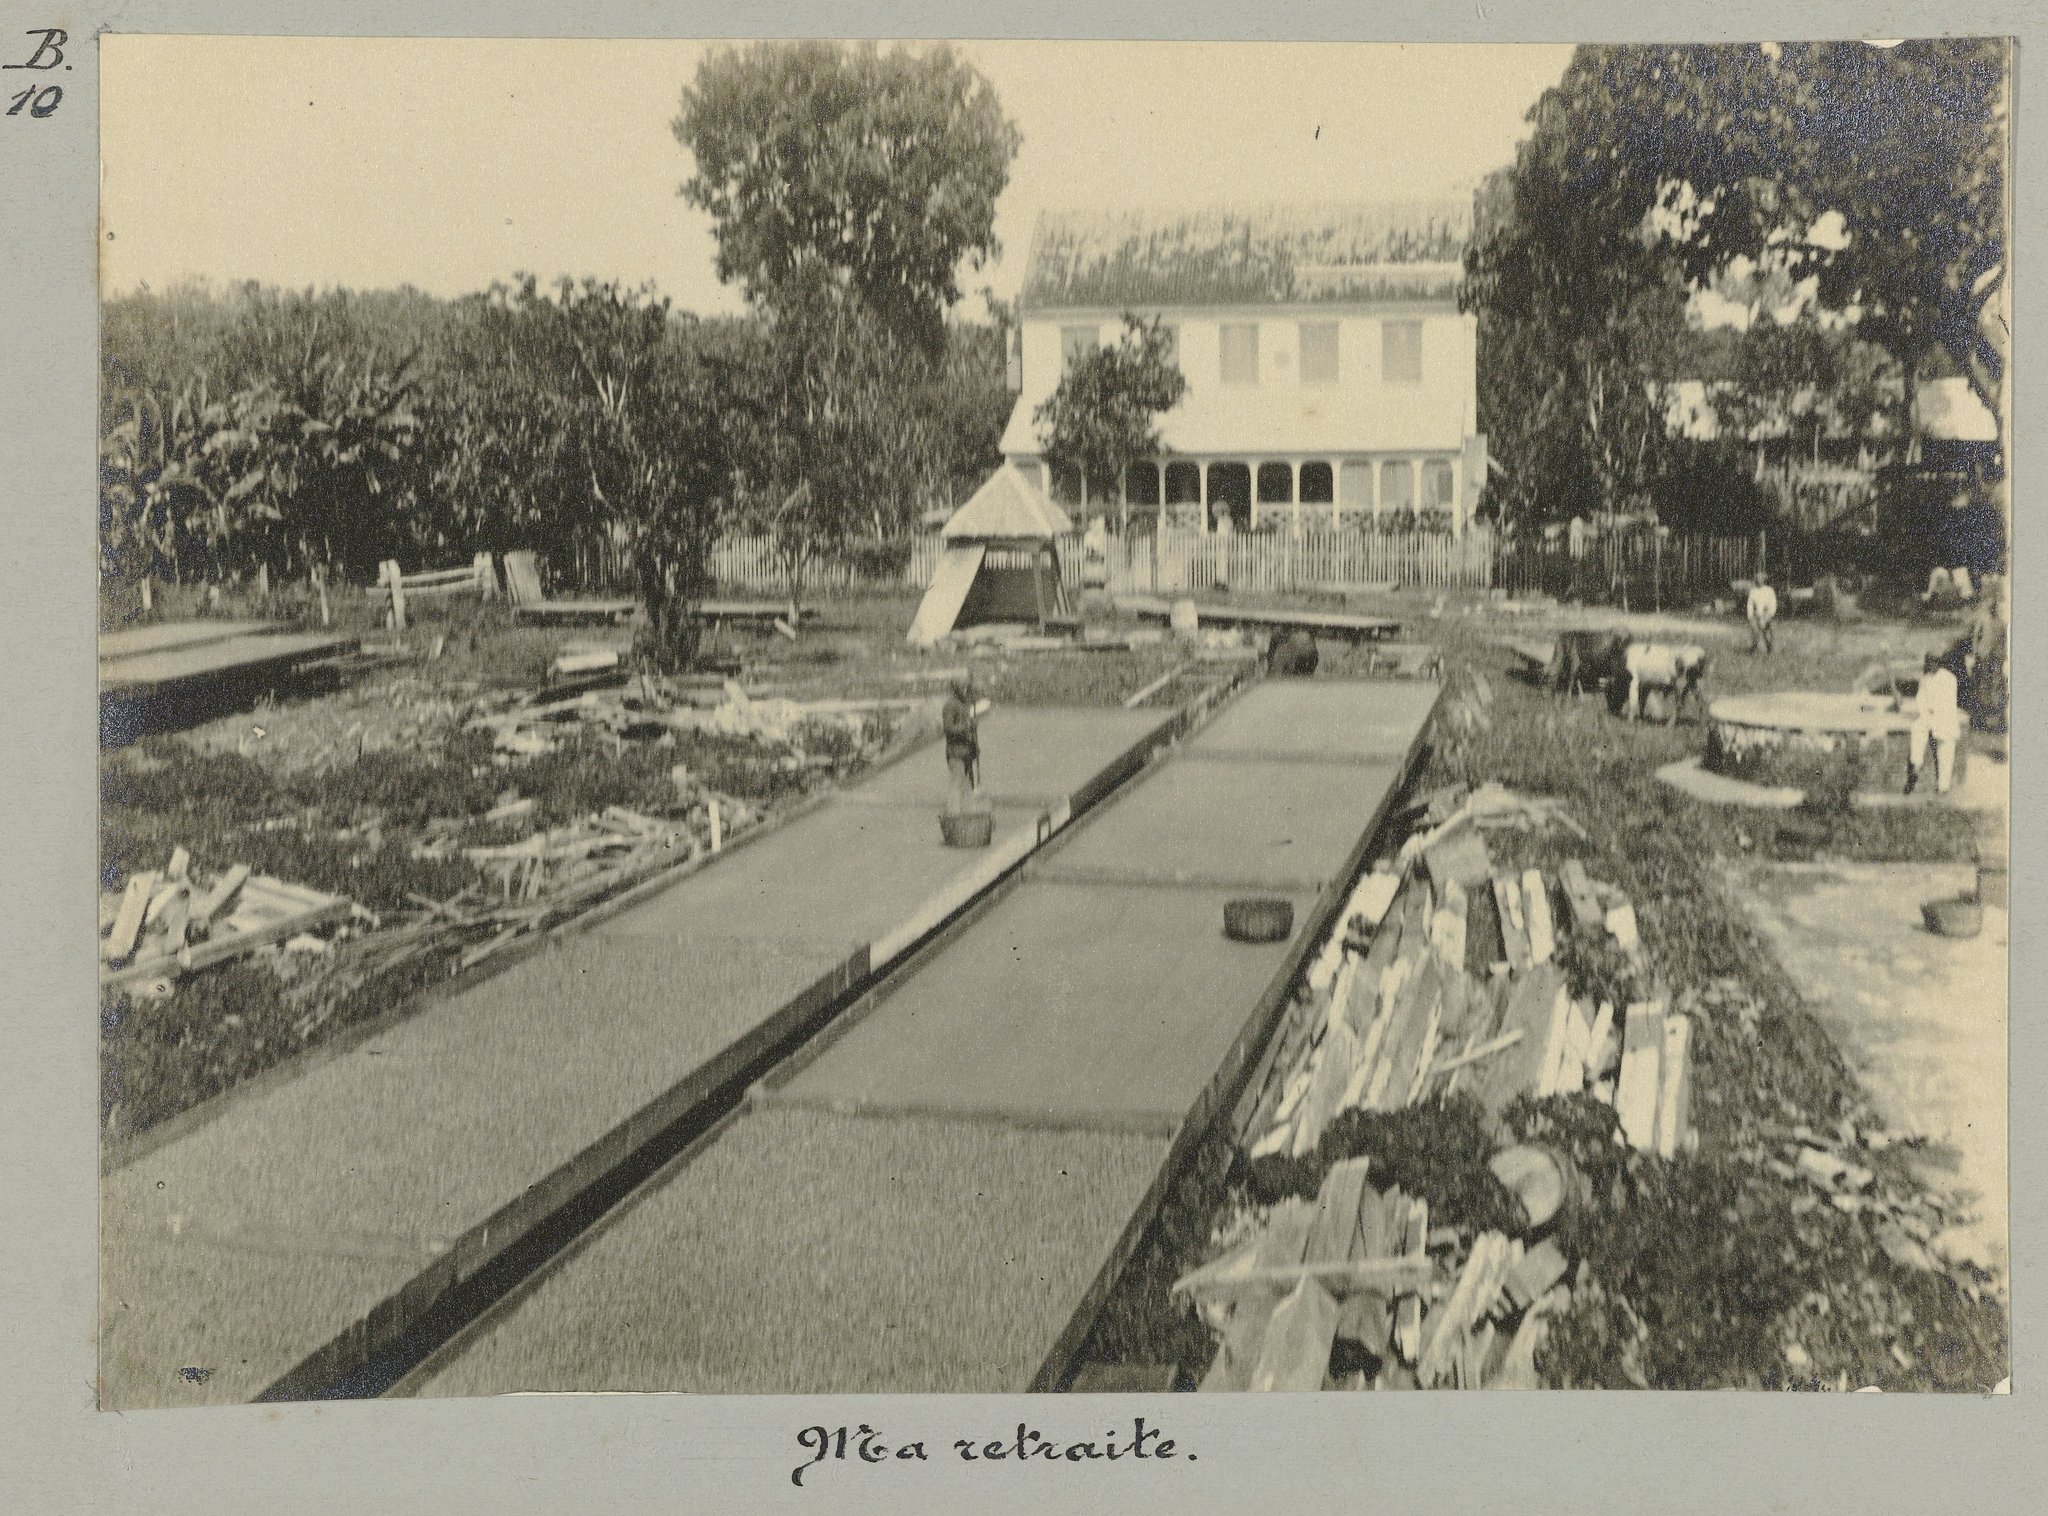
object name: photograph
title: Ma retraite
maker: hendrik doijer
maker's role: engineer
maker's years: 1863-1925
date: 1903-1910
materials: photographic support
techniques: gelatin silver print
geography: suriname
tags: suriname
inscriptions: inscription: ‘B.10 / Ma retraite.’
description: Gezicht op het plantagehuis van Ma retraite. Voor het huis droogbakken met cacaobonen. Onderdeel van het fotoalbum Souvenir de Voyage (deel 2), over het leven van de familie Doijer in en rond de plantage Ma Retraite in Suriname in de jaren 1903-1910.